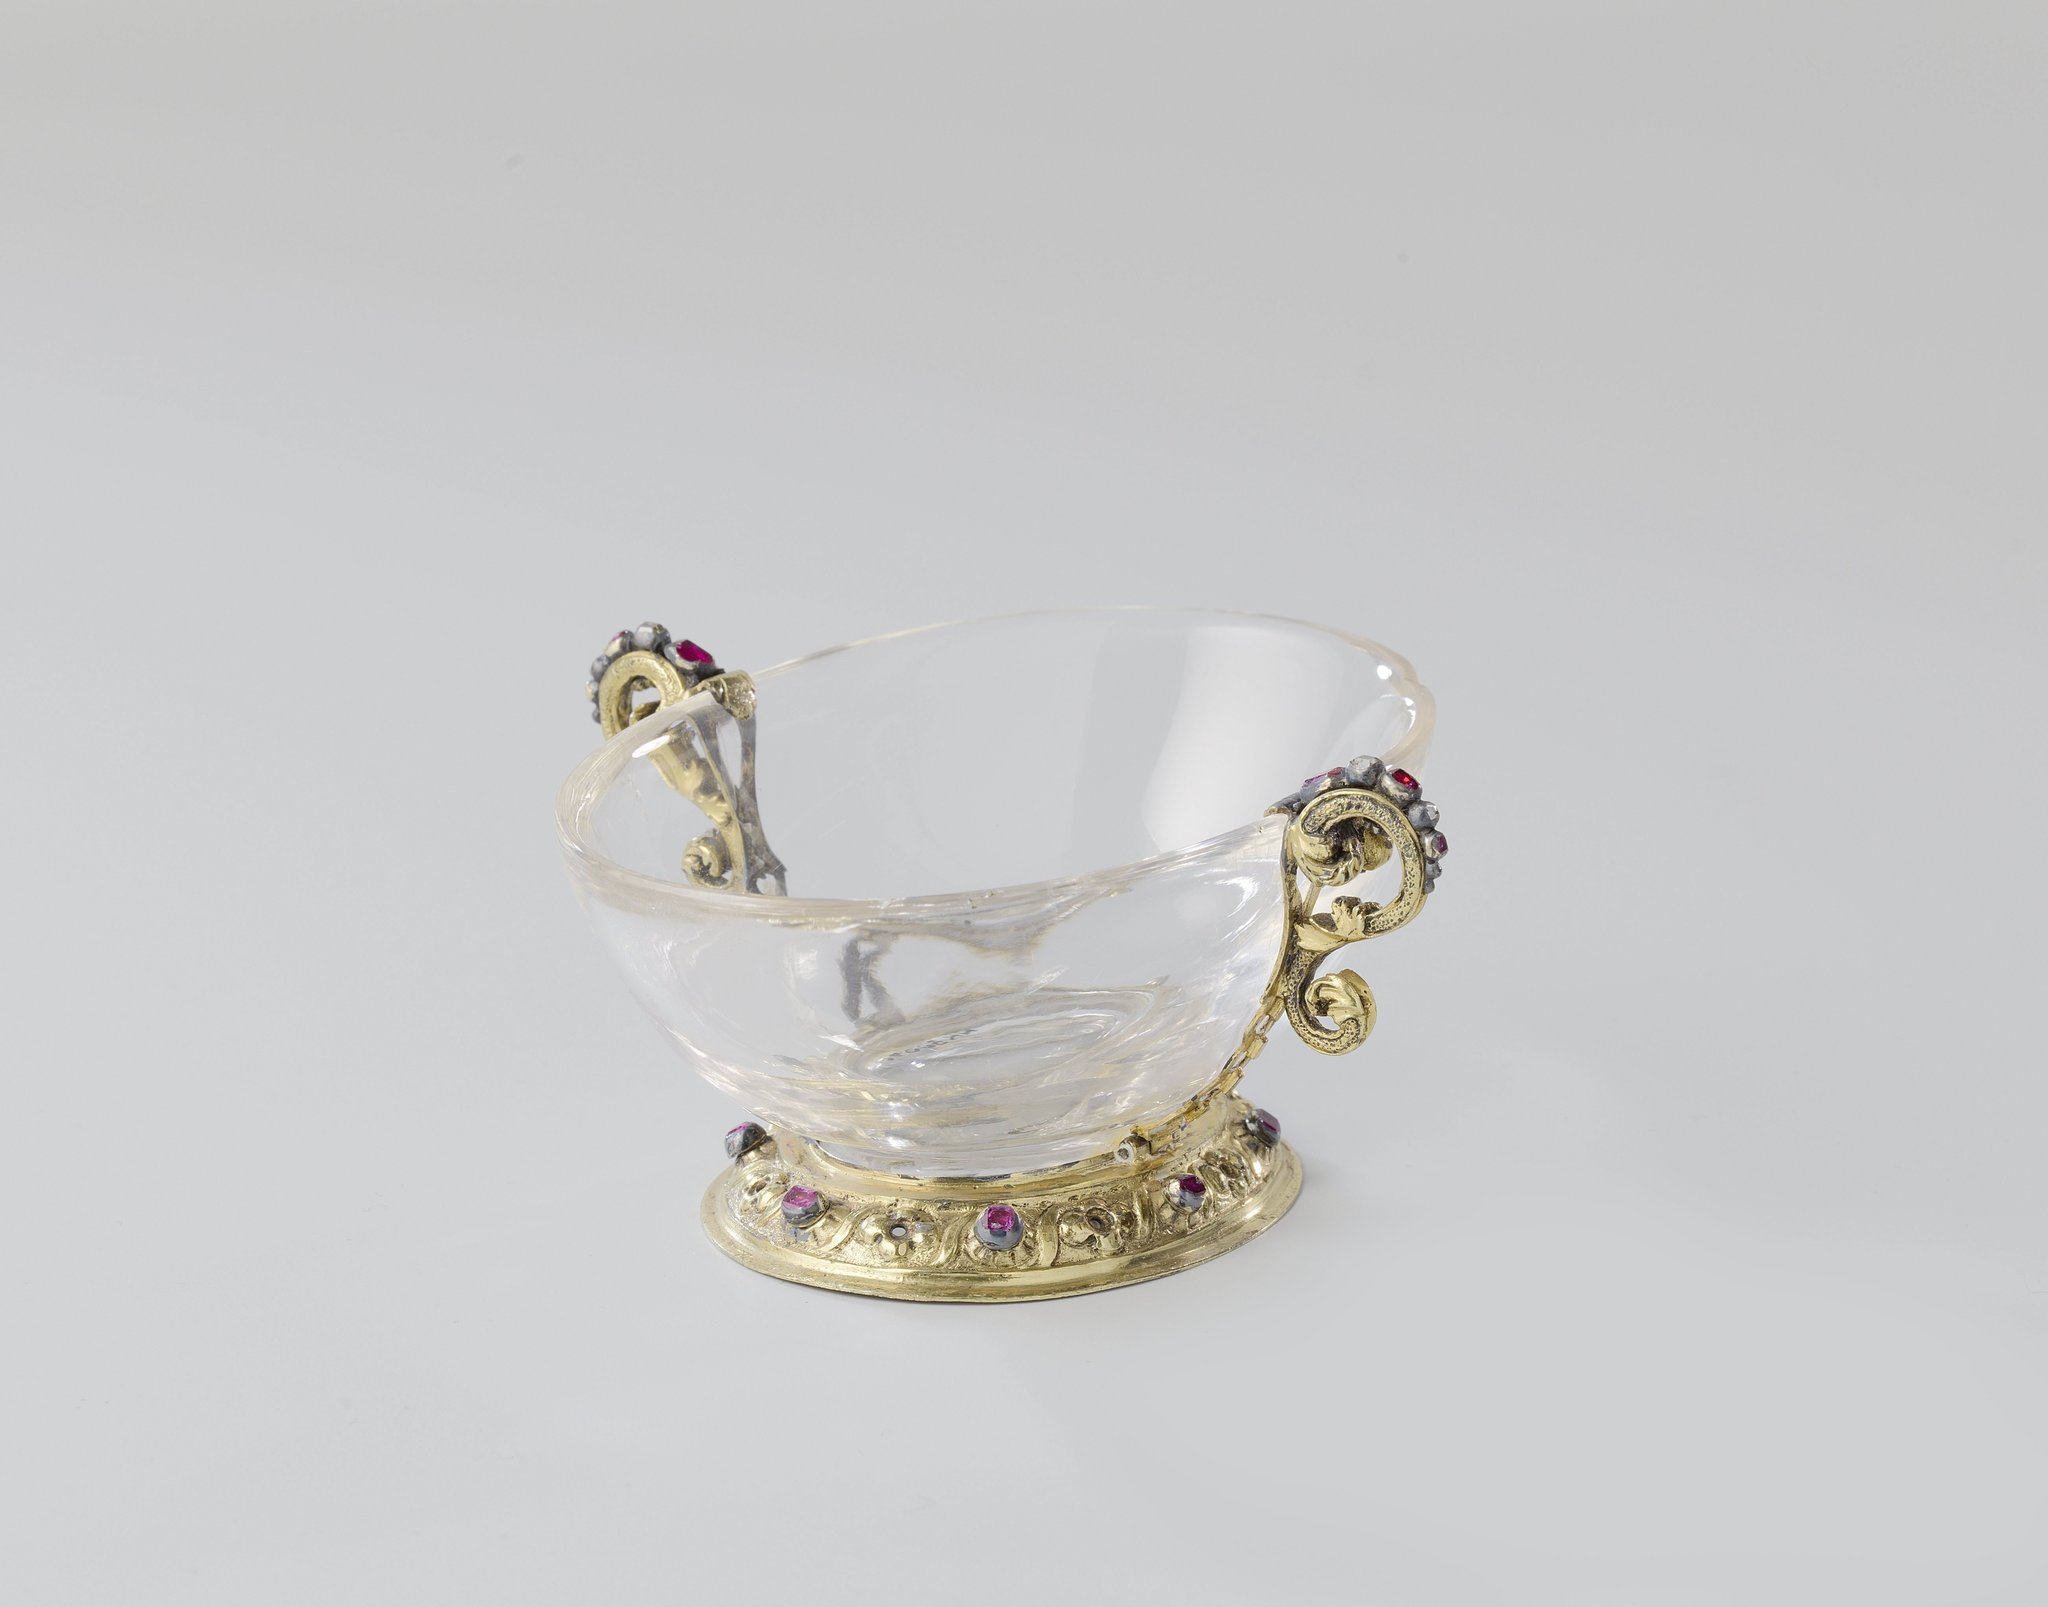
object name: dish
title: Schaal, ovaal, van bergkristal. De twee oren en de voet van verguld zilver met edelstenen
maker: Anonymous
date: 1600-1699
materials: silver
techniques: gilding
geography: germany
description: Bowl. Rock crystal, silver-gilt, diamonds and rubies. Germany, c. 1600-1700.